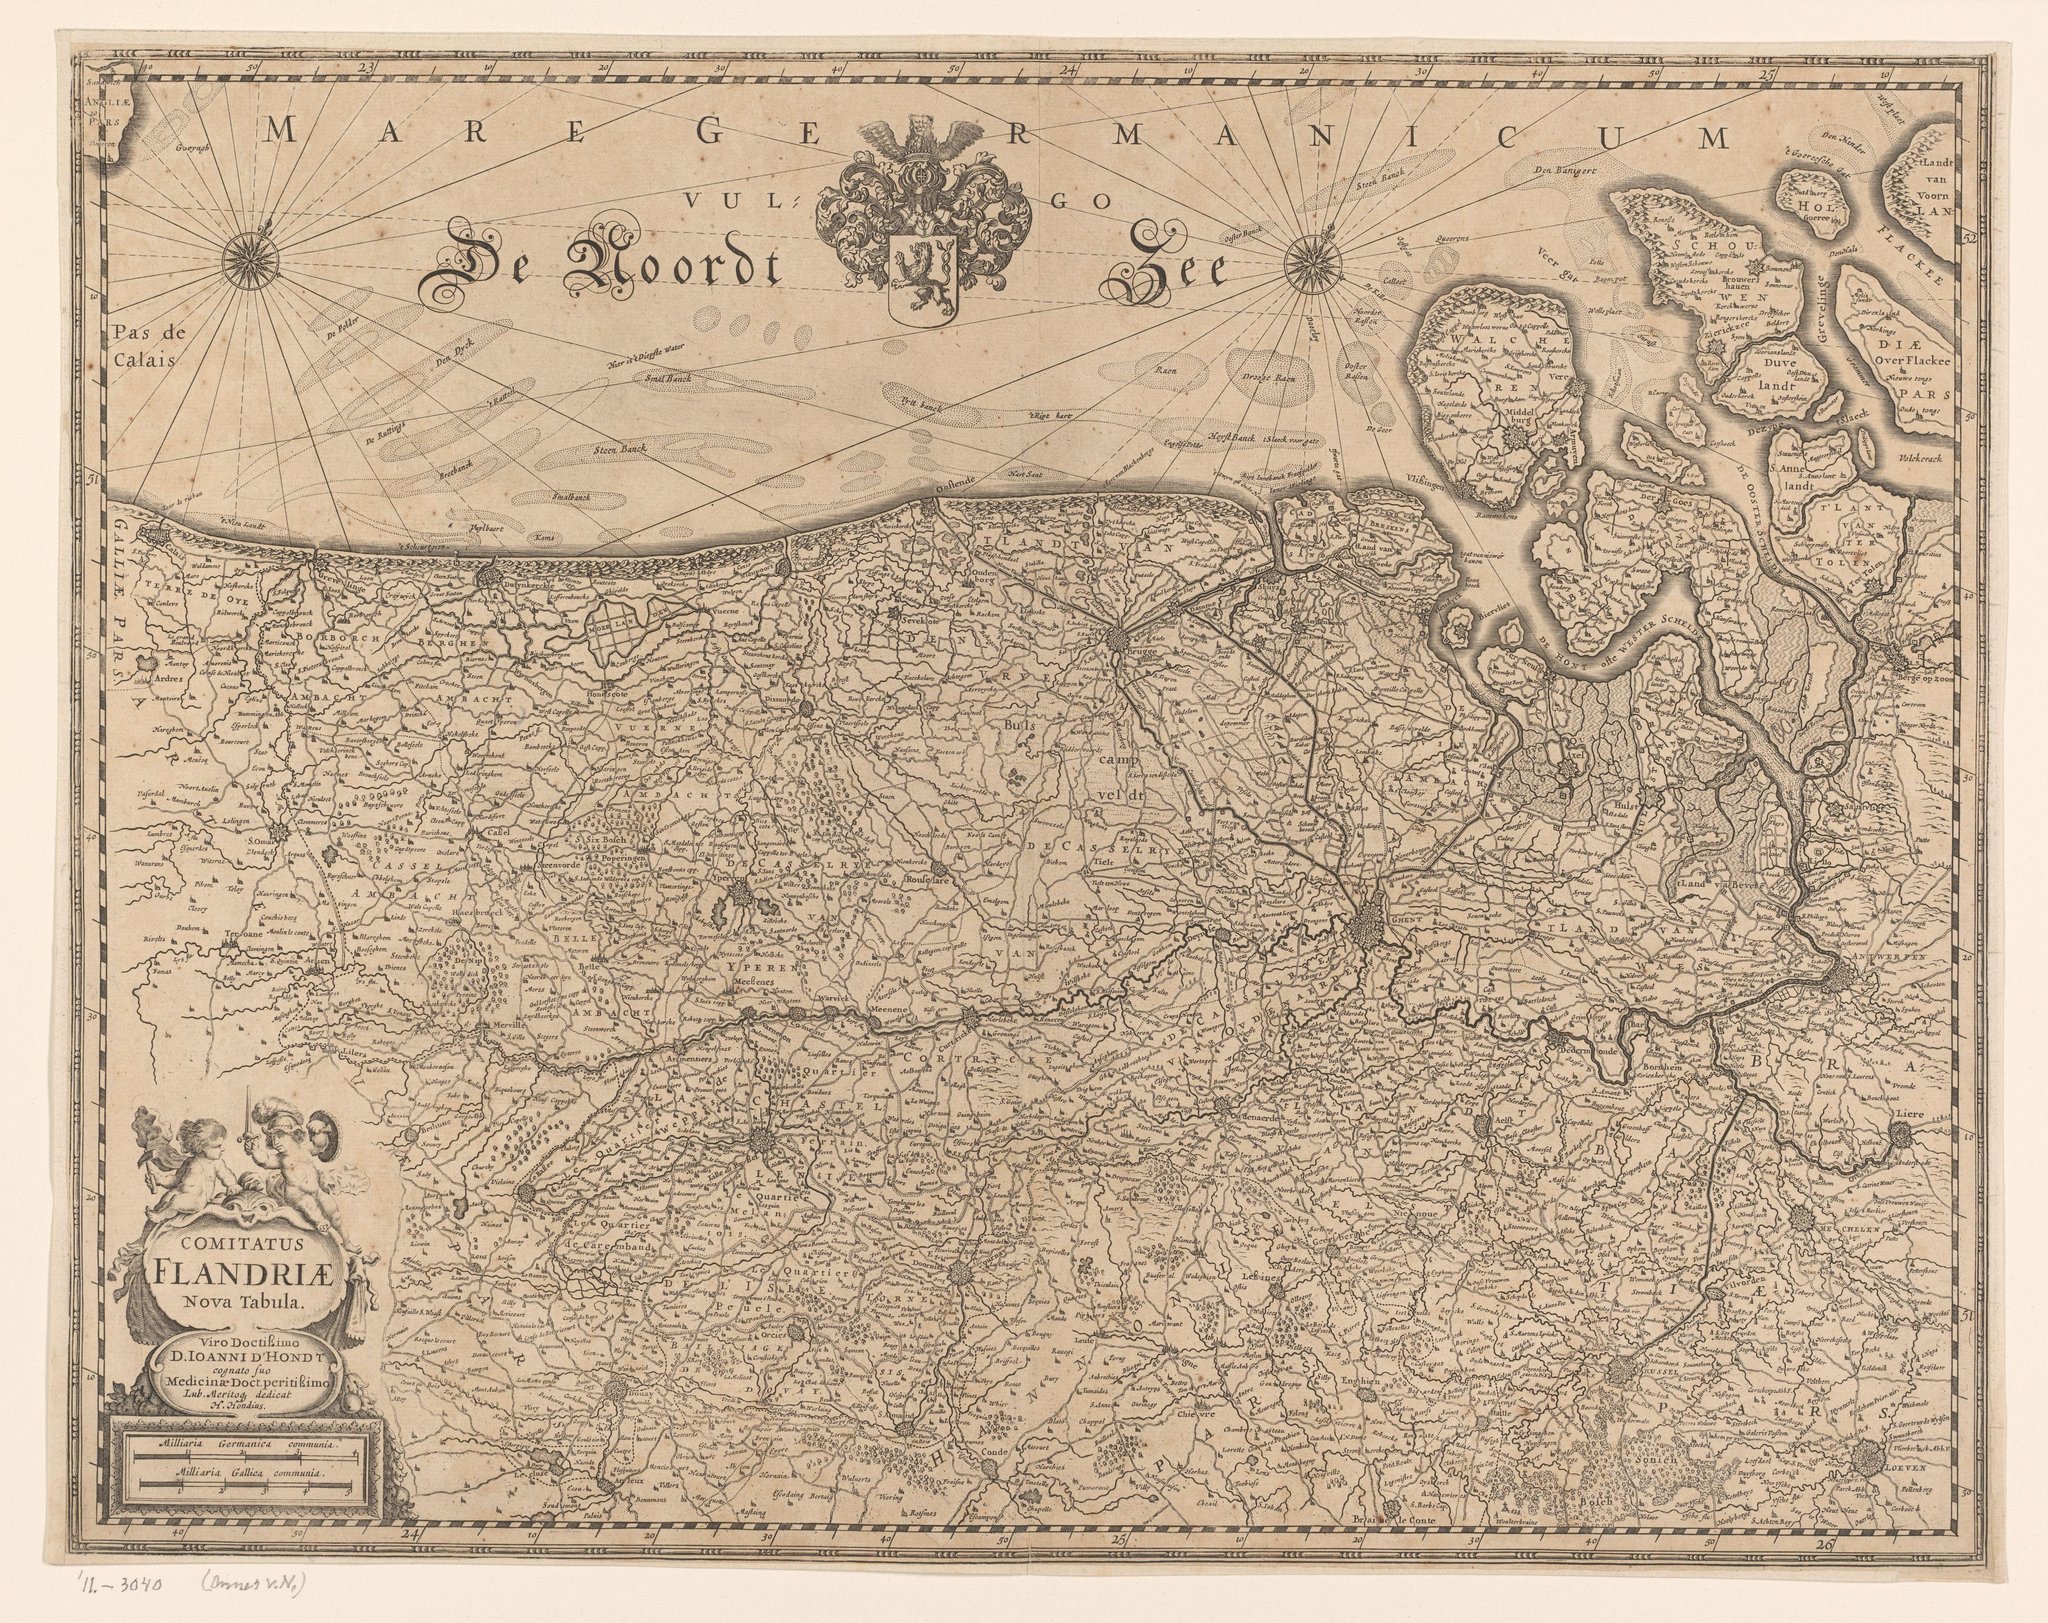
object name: map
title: Comitatus Flandriae nova Tabula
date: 1636-1649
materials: paper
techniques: engraving, etching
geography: amsterdam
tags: maps of separate countries or regions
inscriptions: collector's mark: Lugt 2228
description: Prent onder andere gebruikt in: Mercator, Gerard, en Jodocus Hondius. Atlas Novus sive descriptio Geographica totius Orbis Terrarum, Tabulis Aeneis Luculentissimis & Accuratissimis Exornata, Tribus Tomis Distinctus. Amsterdam: Henricus Hondius, 1638.